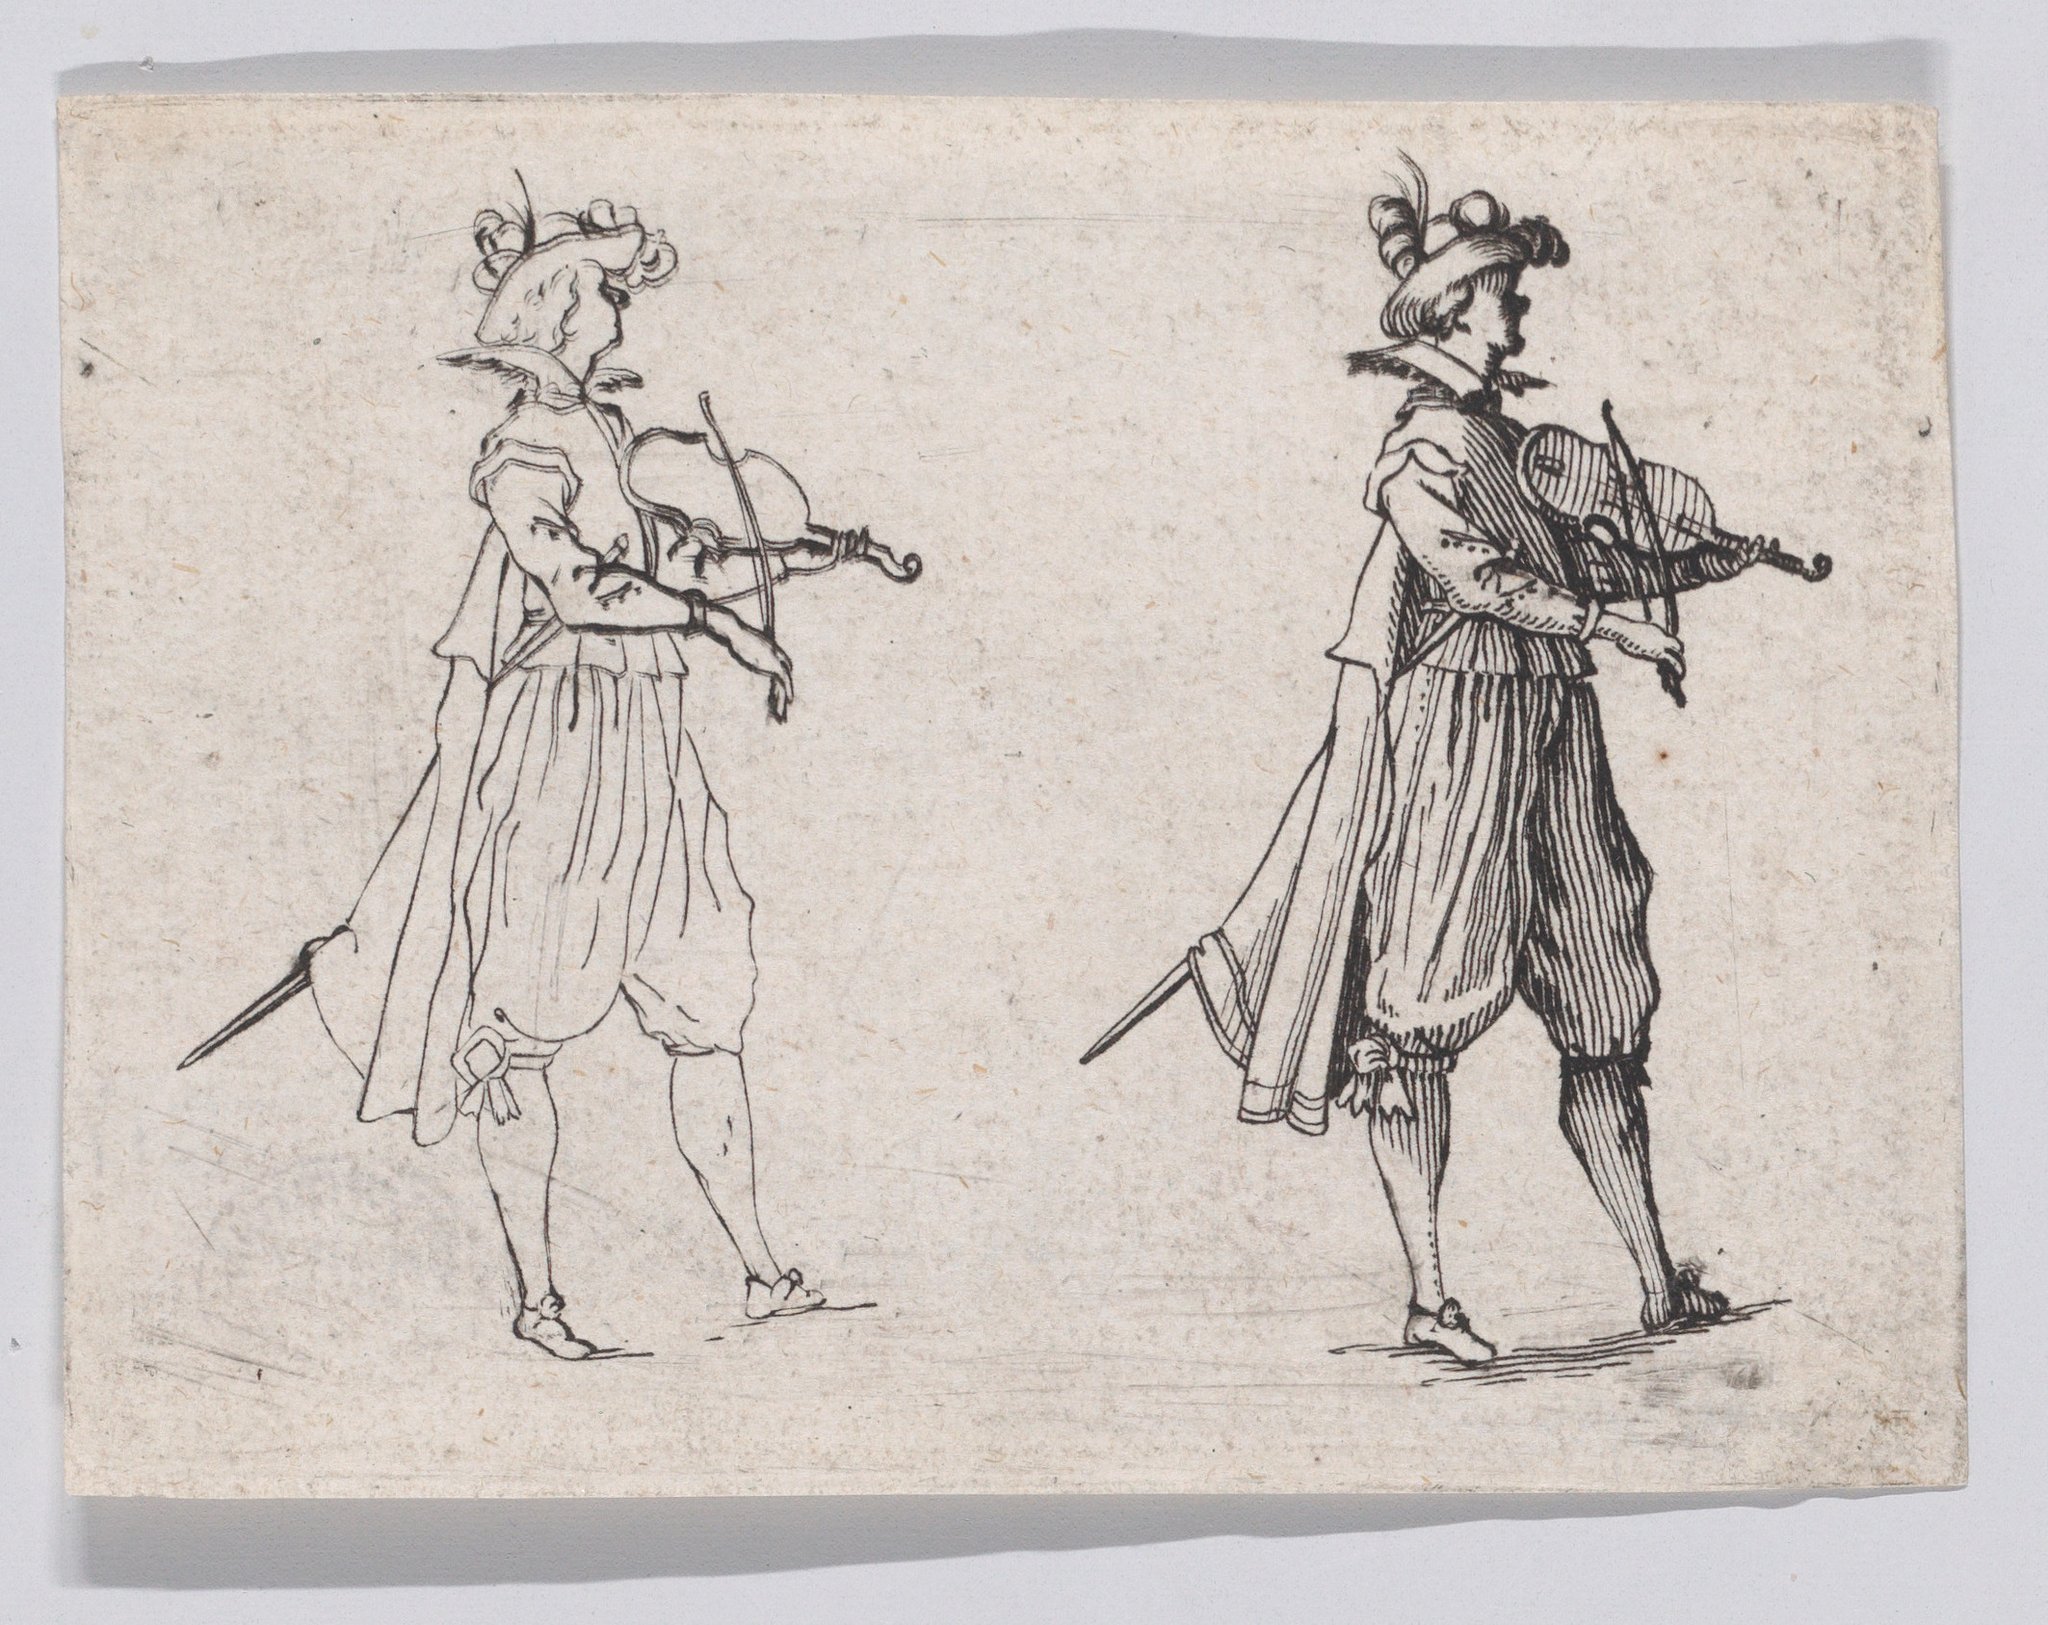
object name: print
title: Copy of Le Joeuer de Violon (The Violin Player), from "Les Caprices"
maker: Anonymous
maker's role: artist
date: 1601-1700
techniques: etching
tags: men,violins,musicians